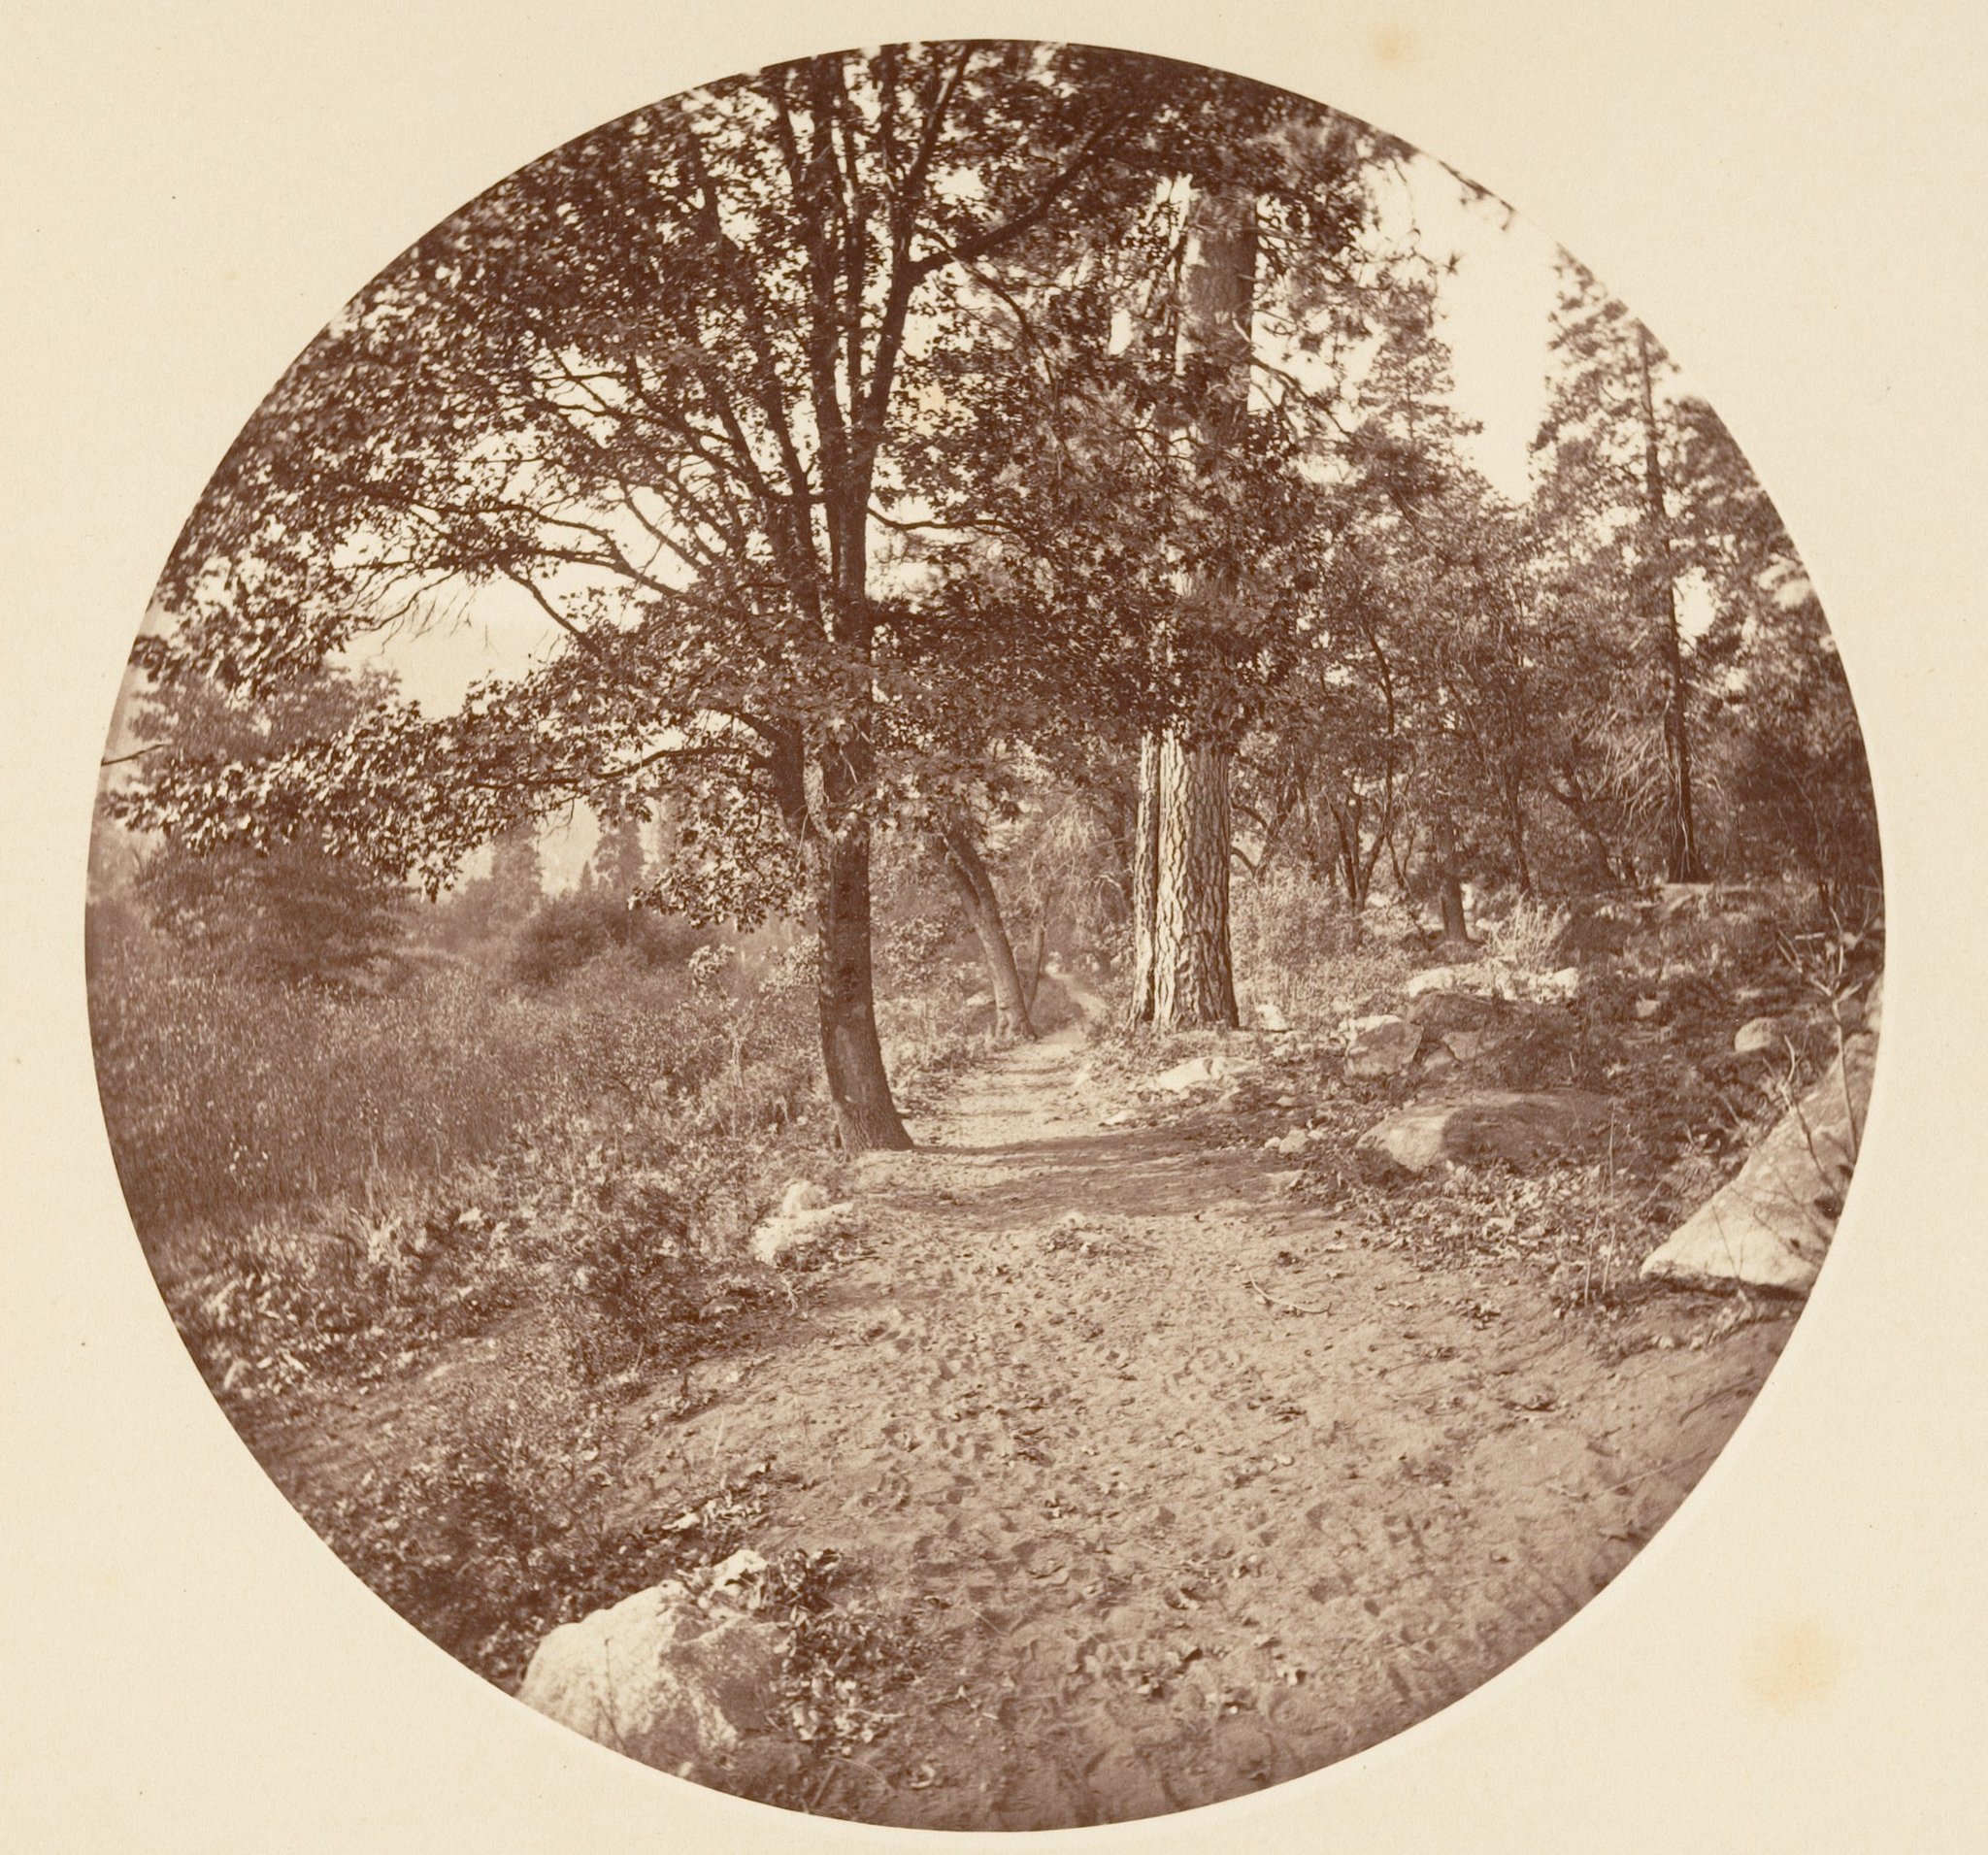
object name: photograph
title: In the Yosemite Valley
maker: carleton e. watkins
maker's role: artist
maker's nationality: american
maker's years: 1829-1916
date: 1878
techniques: albumen silver print, glass negative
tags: landscapes,trees